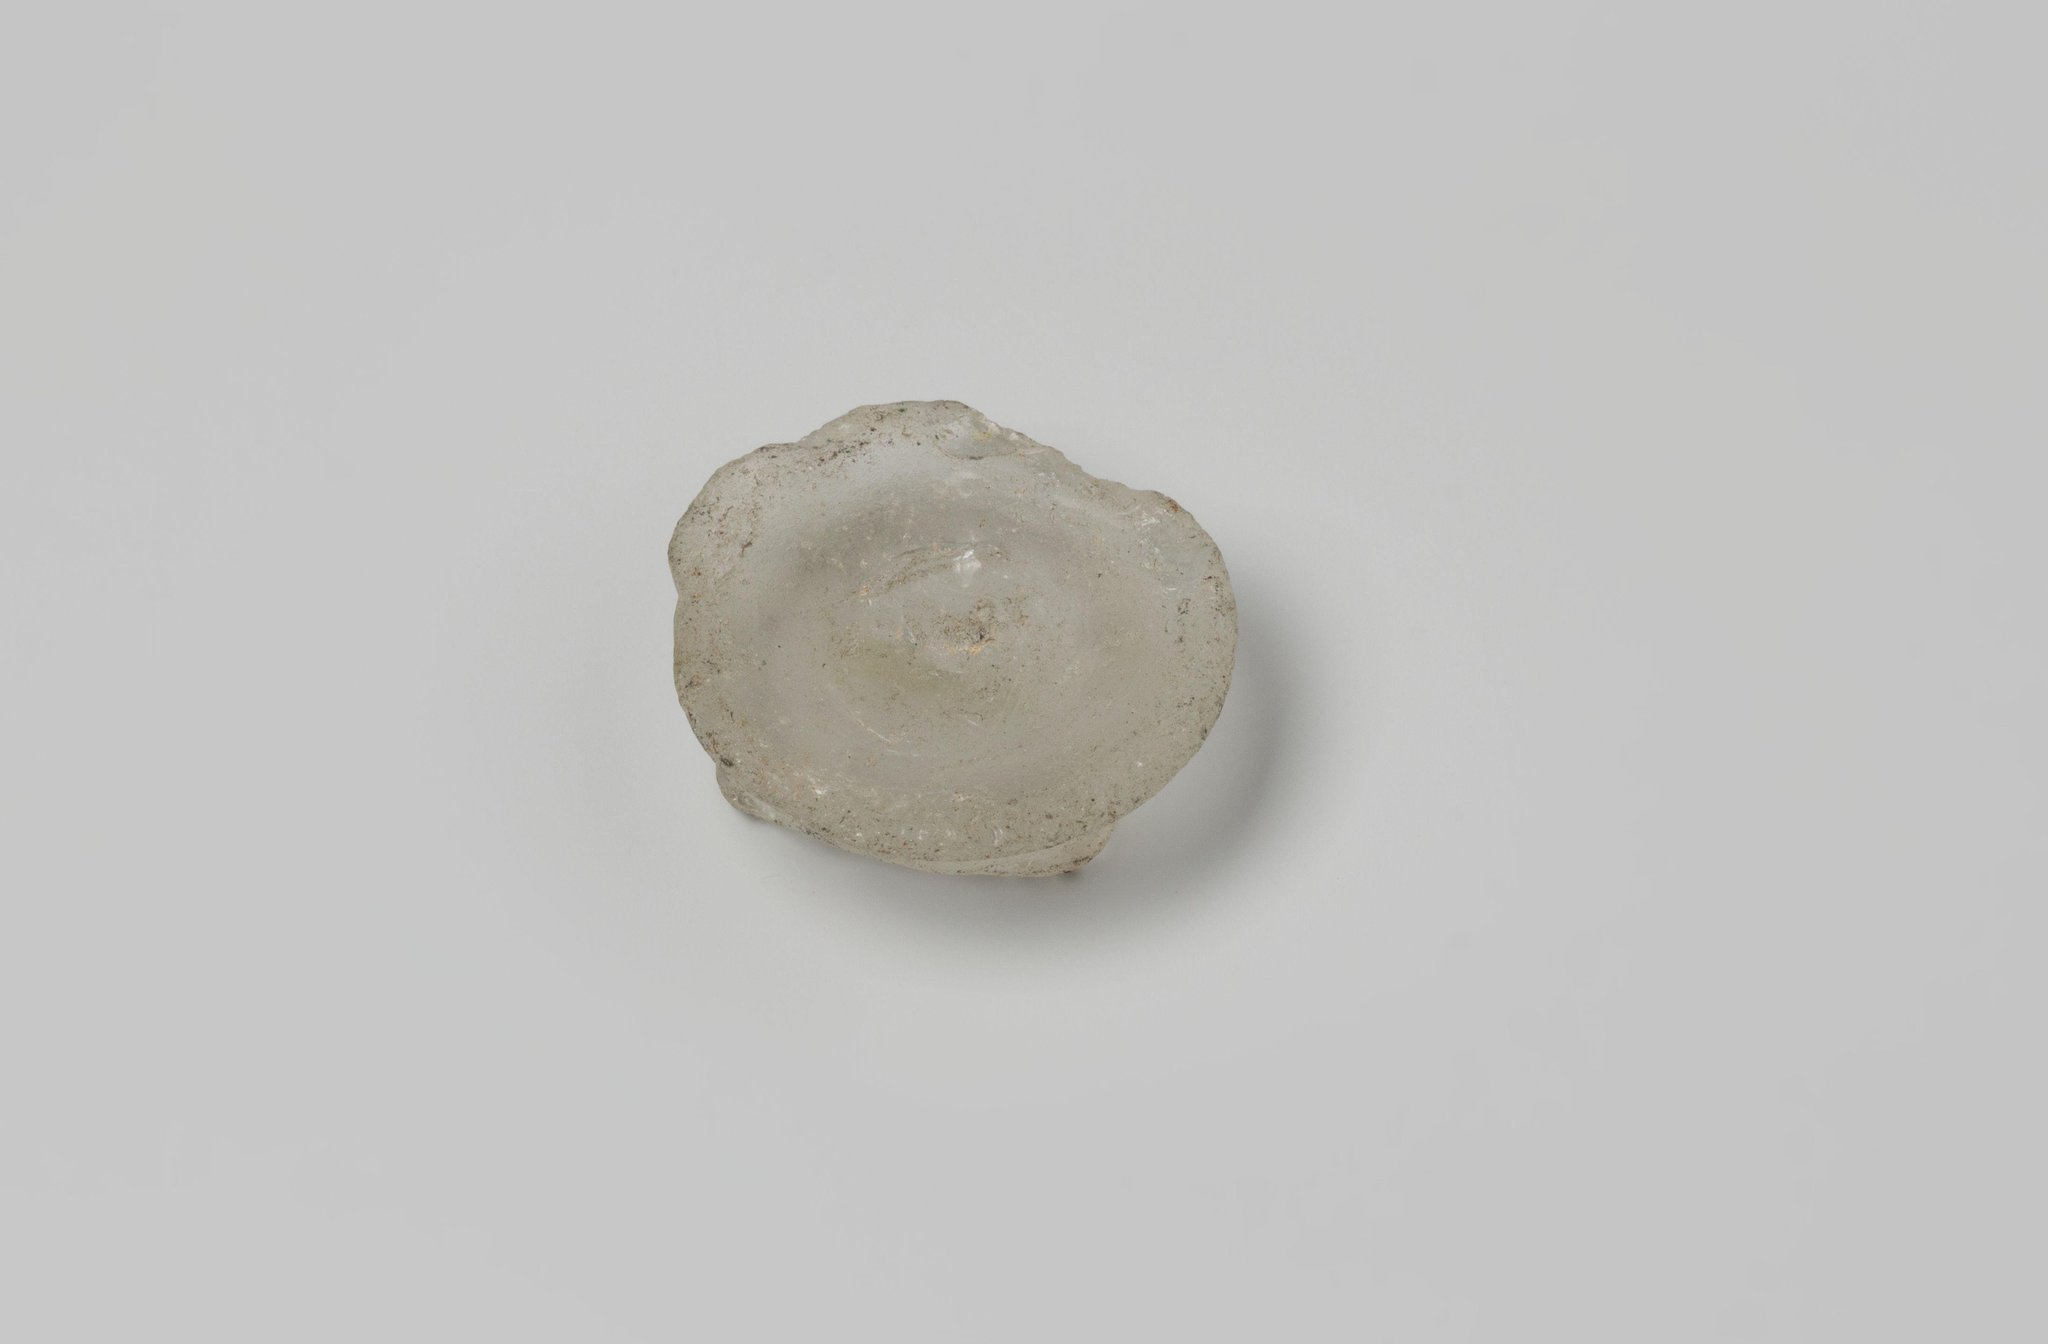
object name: vessel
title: Fragment voet van vaatwerk uit het wrak van de Oost-Indiëvaarder Hollandia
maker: Anonymous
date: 1700-1743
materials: glass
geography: netherlands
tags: verenigde oostindische compagnie, hollandia (schip), annet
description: Vessel part, basal feet; fragm, circular, bevelled rim, concave underneath.